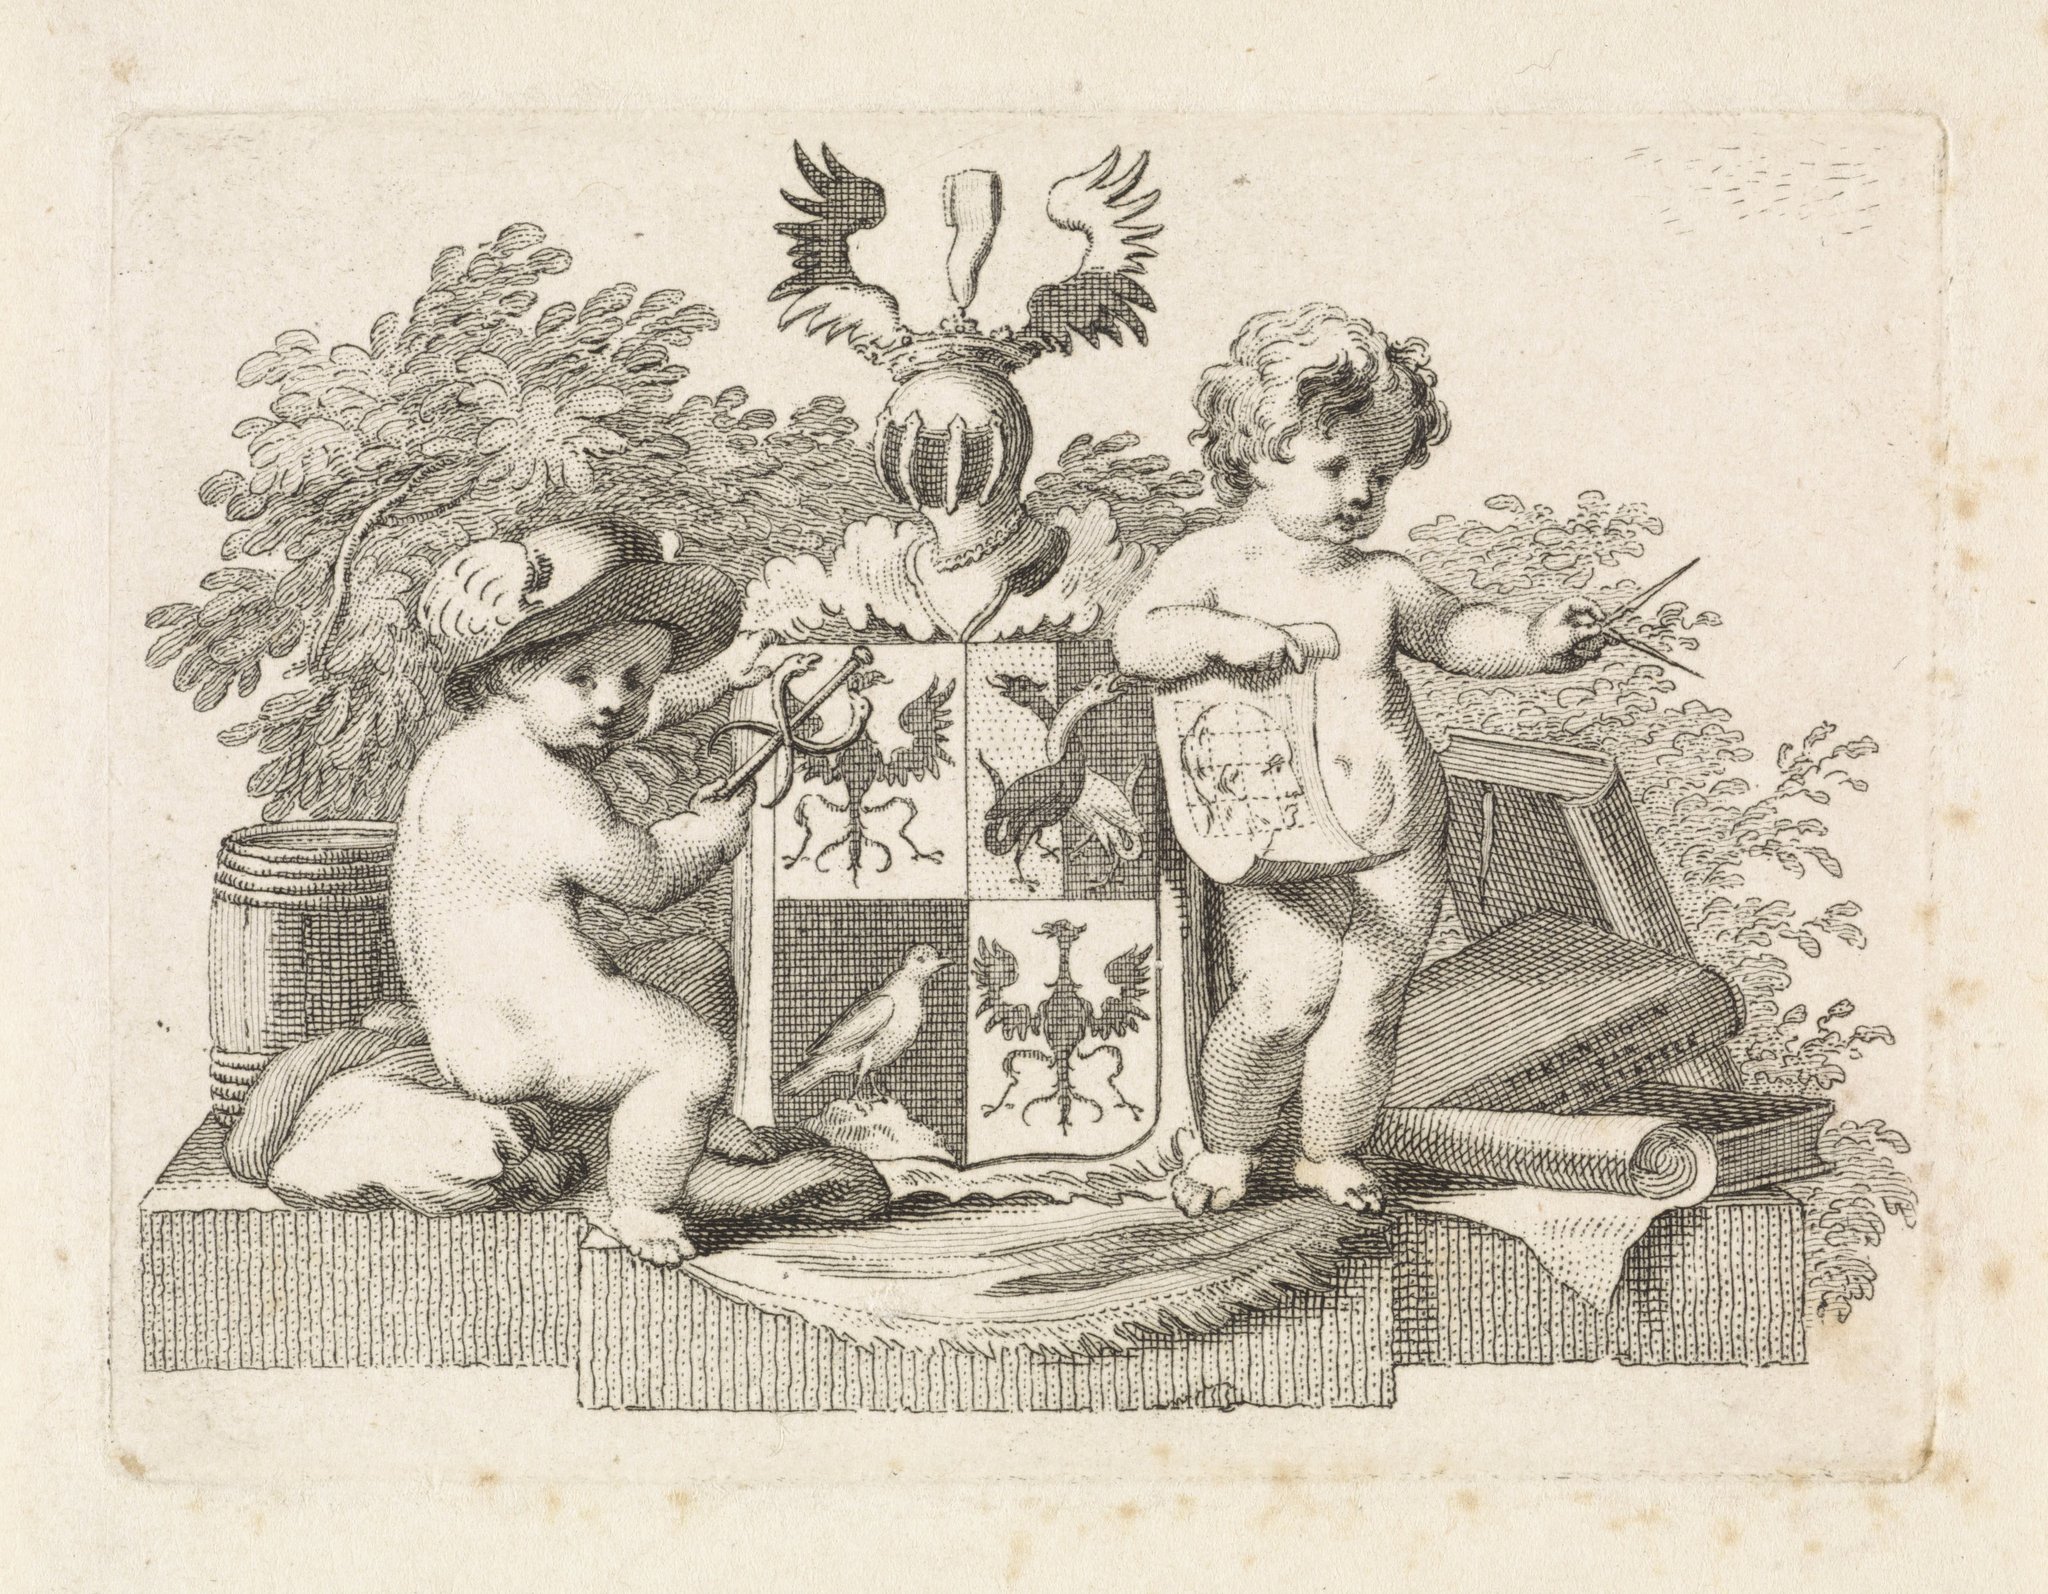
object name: print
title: Familiewapen van Goll van Frankenstein, geflankeerd door twee putti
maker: reinier vinkeles (i)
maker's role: draughtsman, print maker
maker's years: 1741-1816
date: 1773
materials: paper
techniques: engraving, etching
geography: amsterdam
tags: compasses, attributes of mercury, cupids: 'amores', 'amoretti', 'putti'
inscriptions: collector's mark: Lugt 240